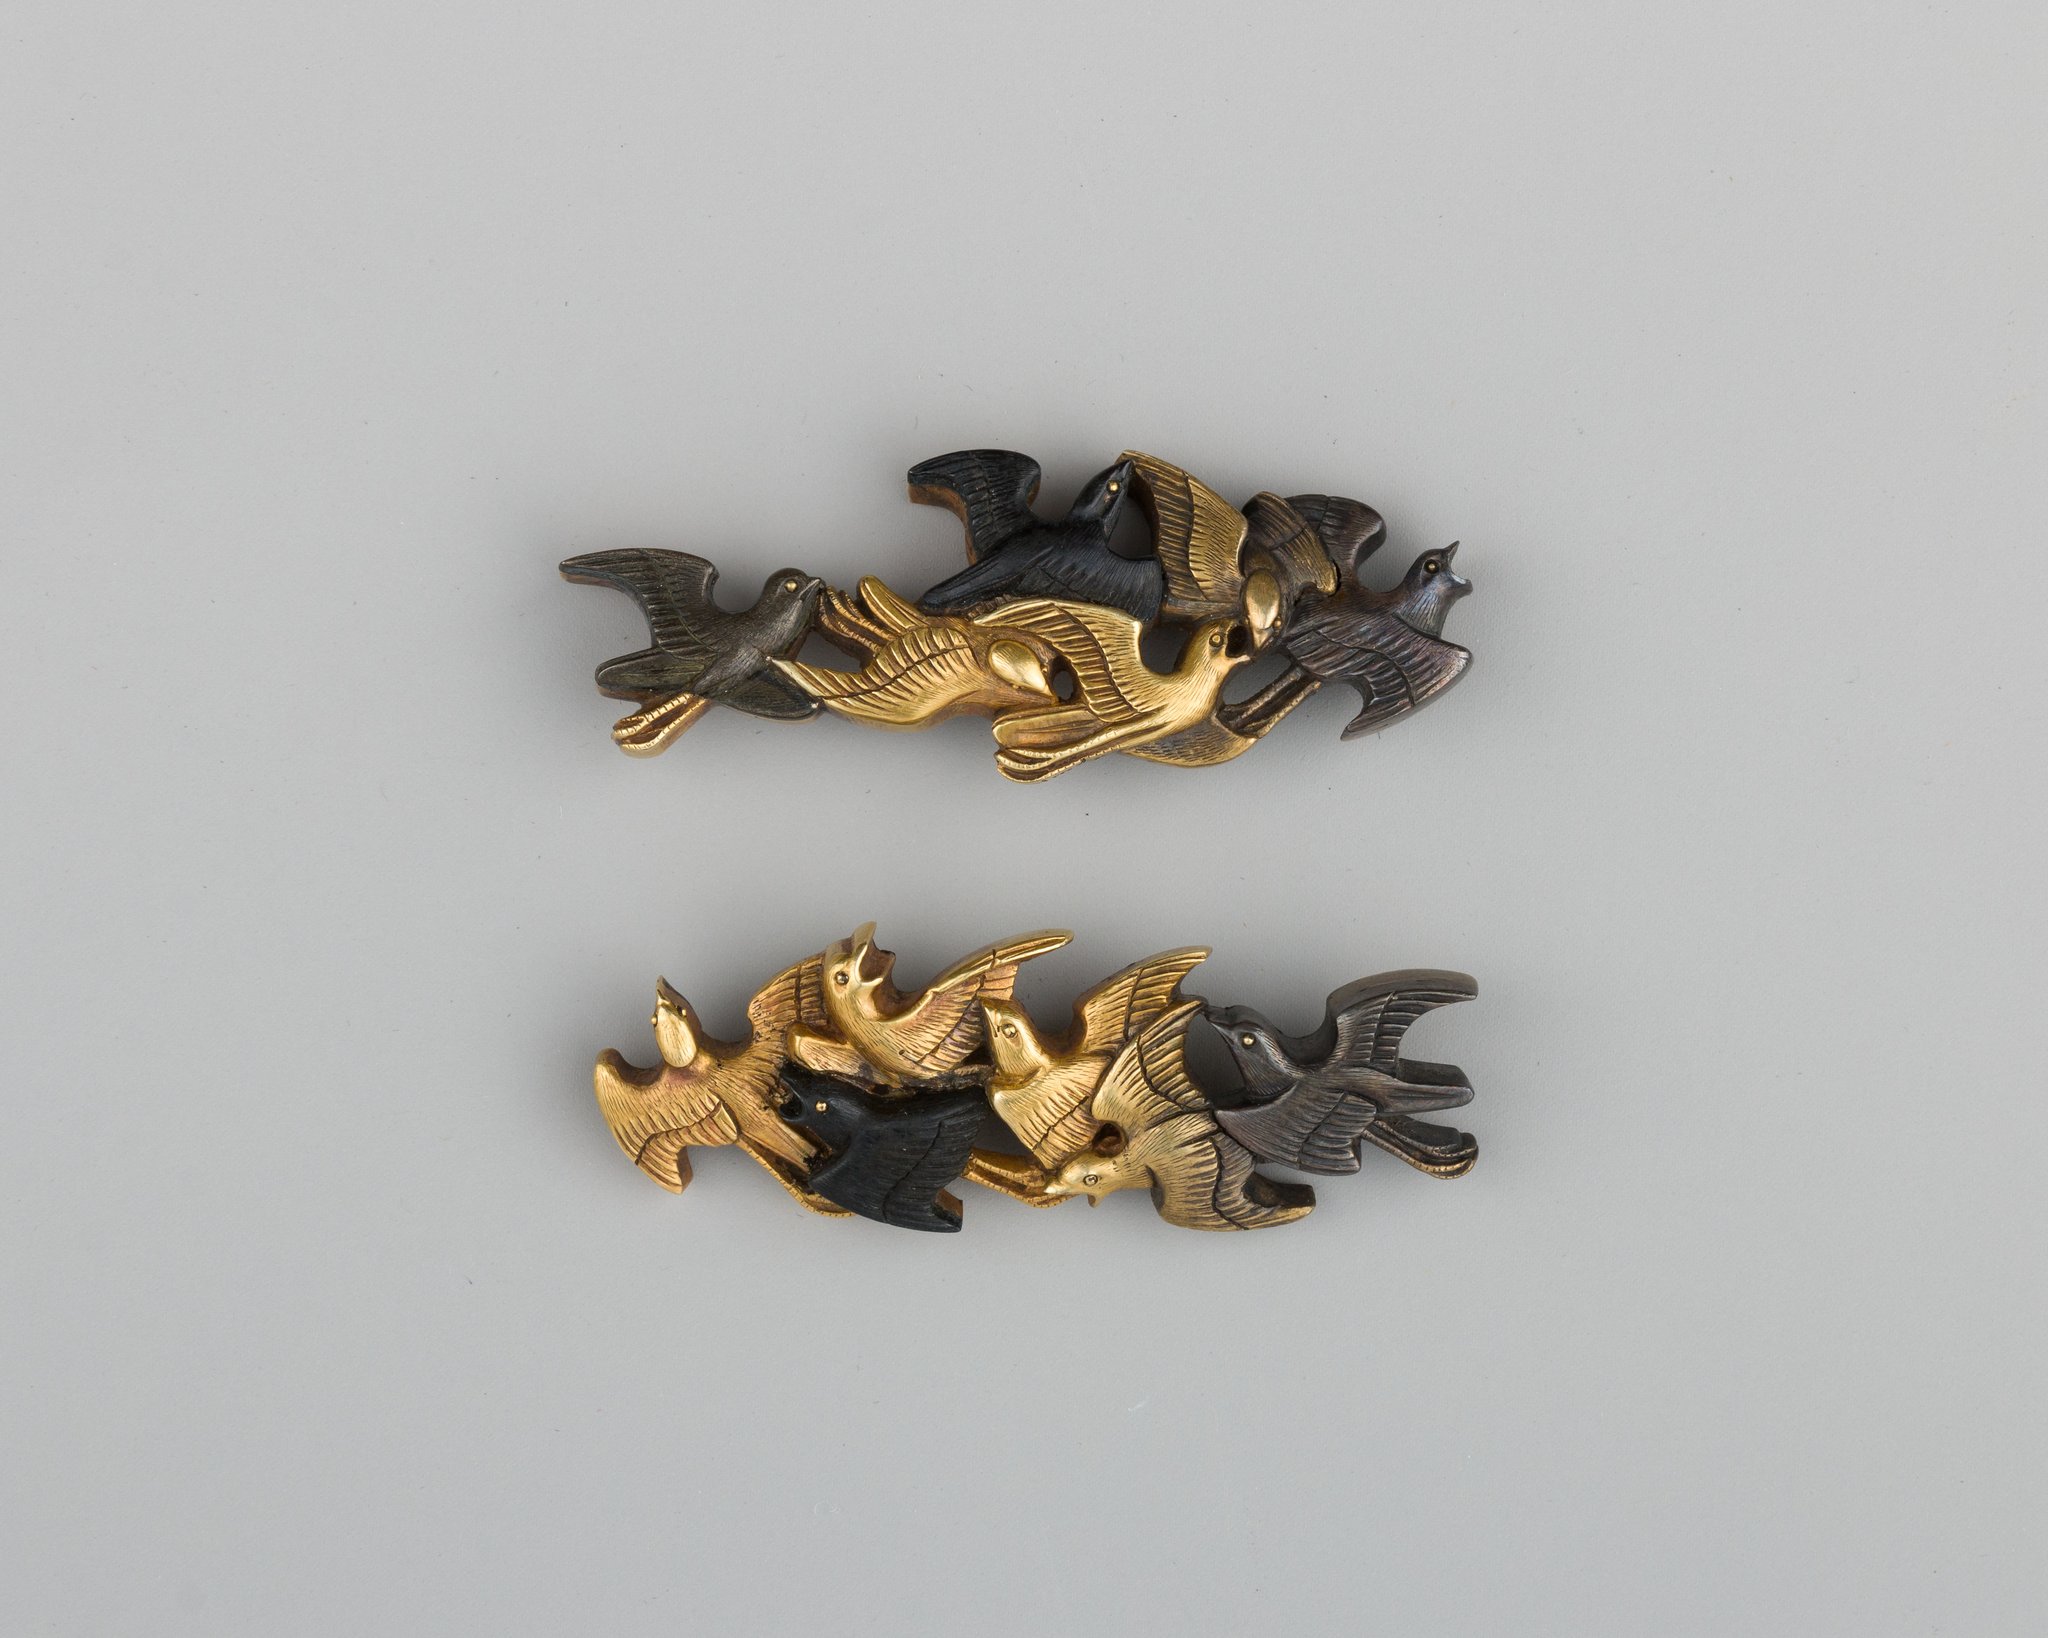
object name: pair of sword grip ornament menuki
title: Pair of Sword-Grip Ornaments (Menuki)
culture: japanese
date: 1701-1800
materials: gold alloy, silver alloy, gold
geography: japan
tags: birds